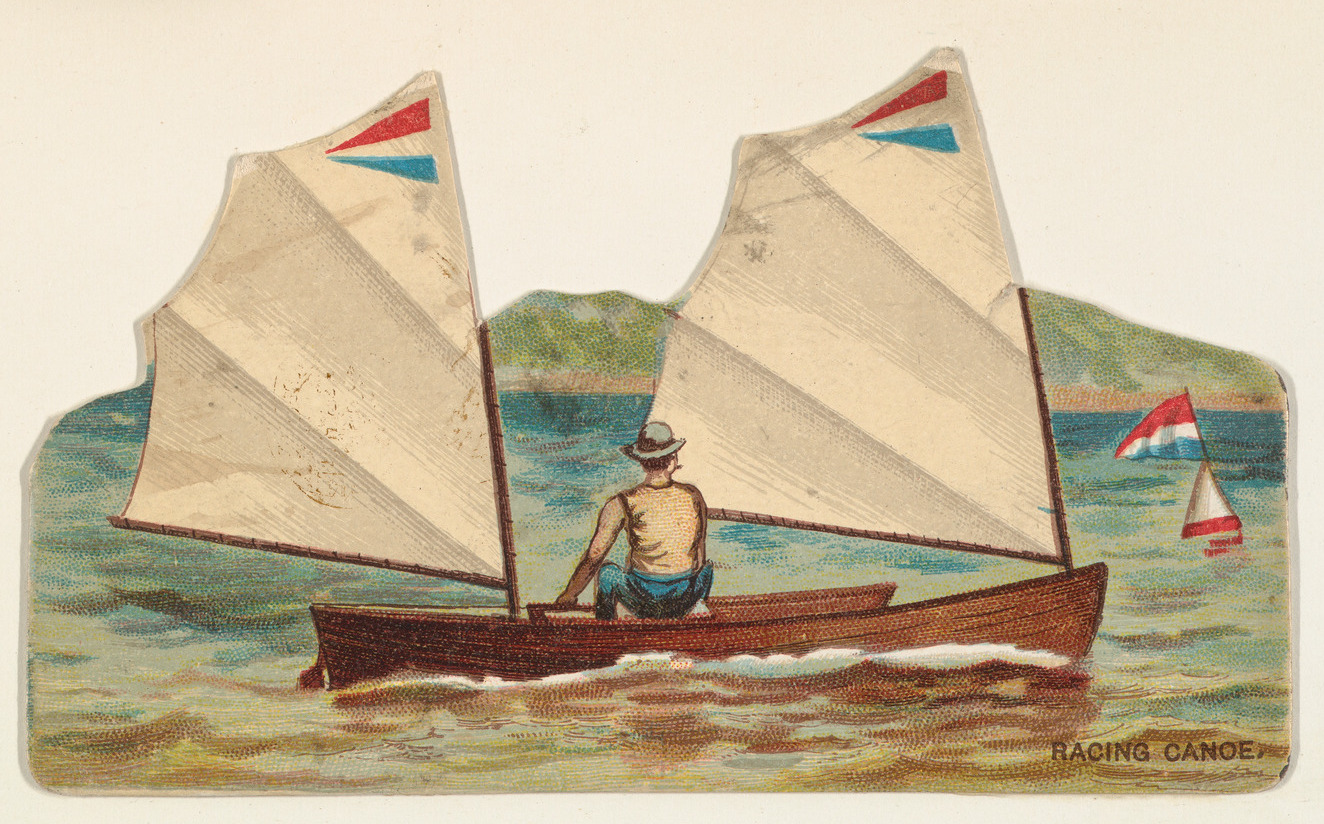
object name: print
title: Racing Canoe, from the Types of Vessels series (N139) issued by Duke Sons & Co. to promote Honest Long Cut Tobacco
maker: w. duke, sons & co.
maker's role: publisher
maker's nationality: american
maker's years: 1870-1920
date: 1889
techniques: color lithograph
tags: boats